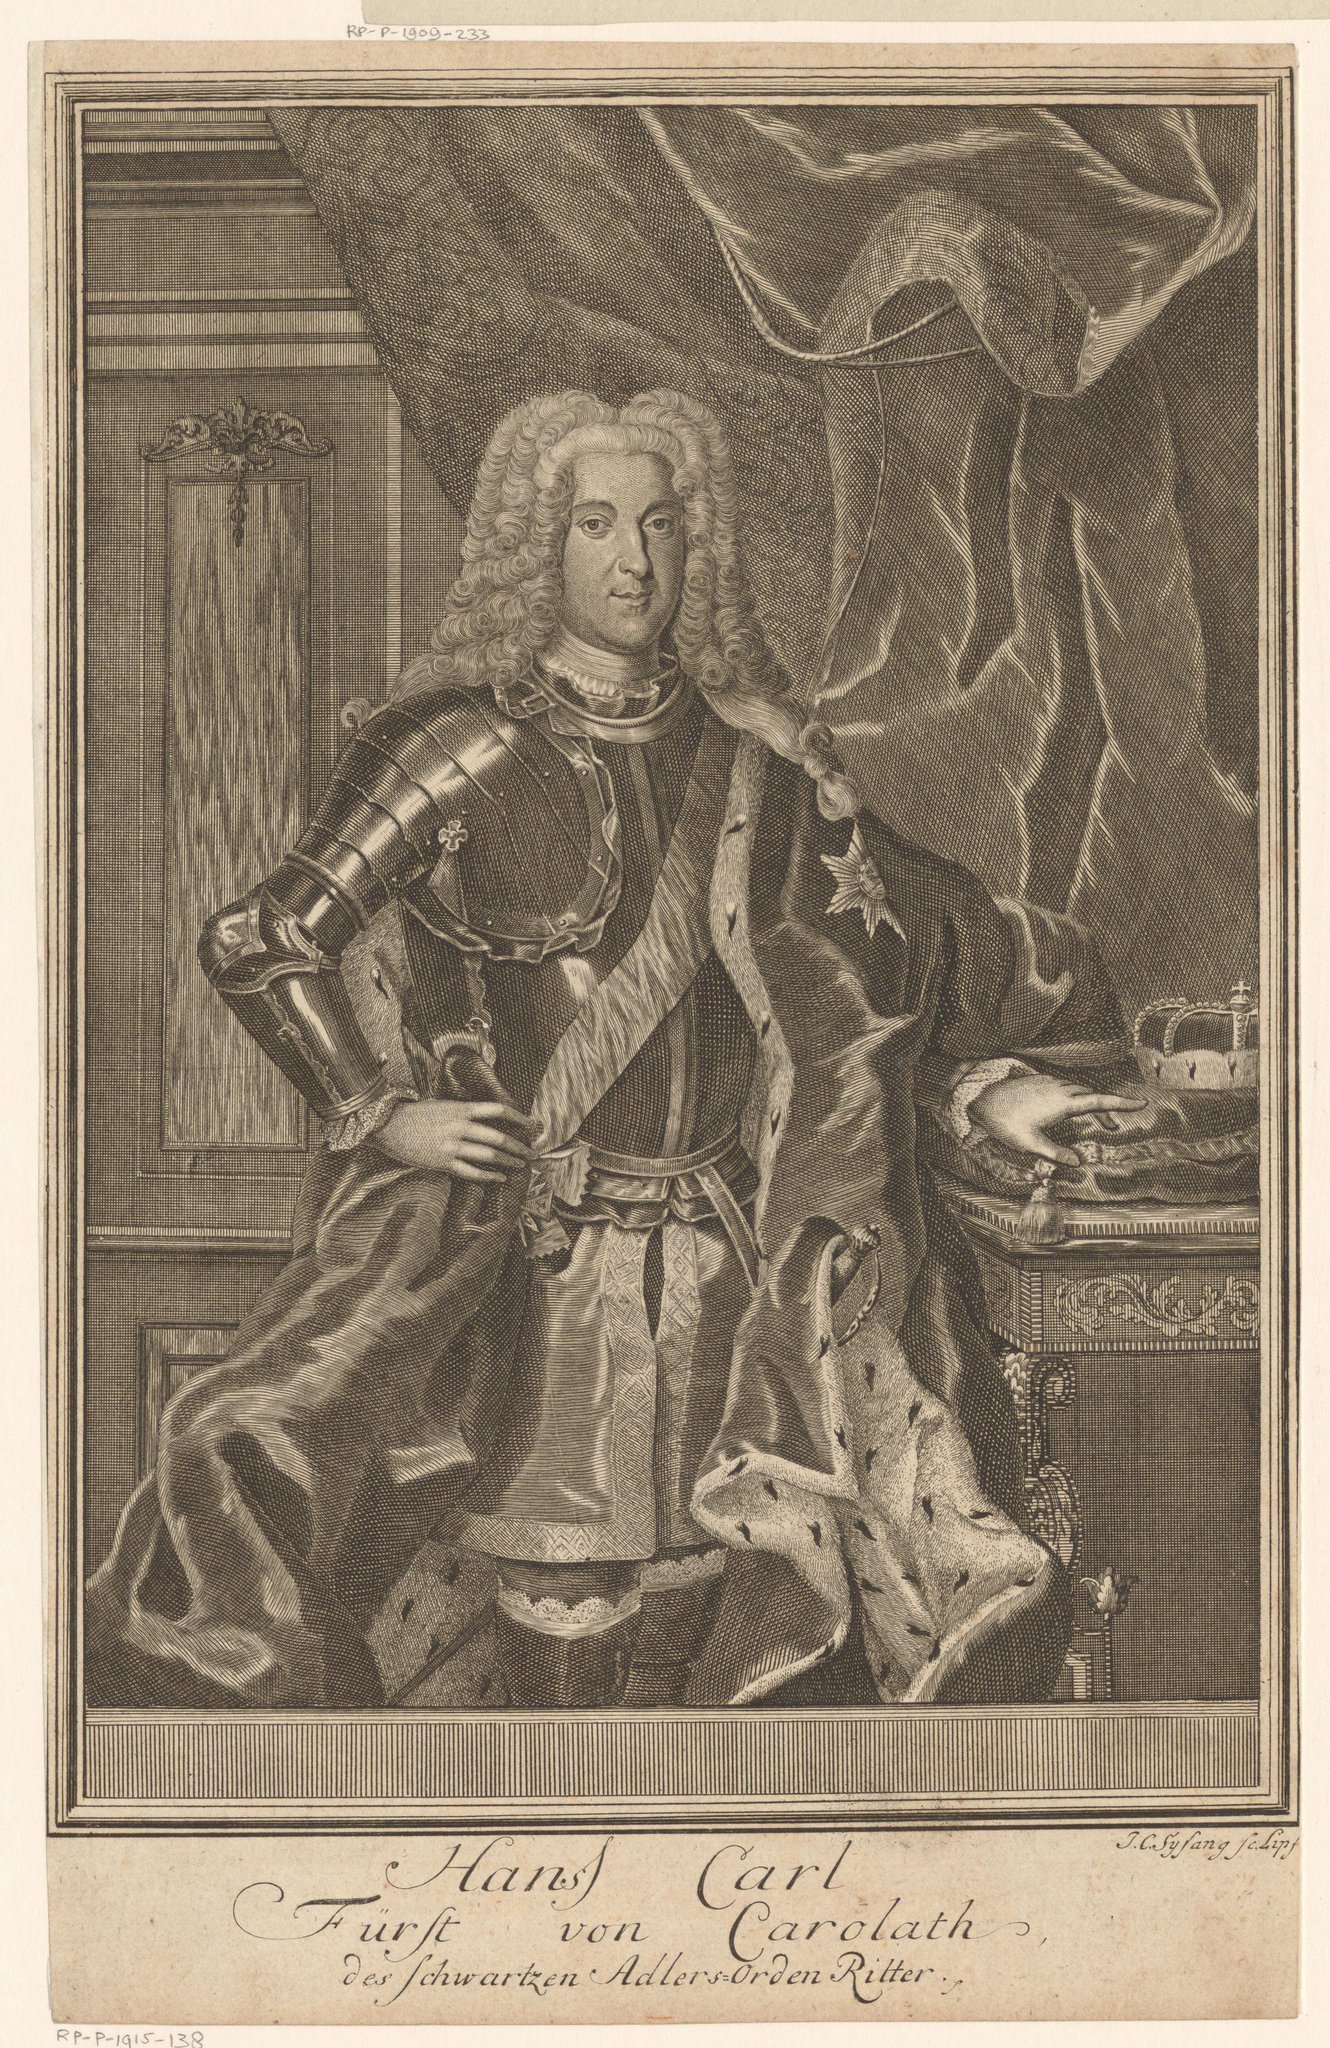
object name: print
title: Portret van Hans Carl, Fürst von Carolath-Beuthen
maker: johann christoph sysang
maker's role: print maker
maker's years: 1703-1757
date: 1741-1757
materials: paper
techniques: engraving, etching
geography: leipzig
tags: poland, crown (symbol of sovereignty), knighthood order (with name) - insignia of a knighthood order, e.g.: badge, chain (with name of order), armour, historical persons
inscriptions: collector's mark: Lugt 2228